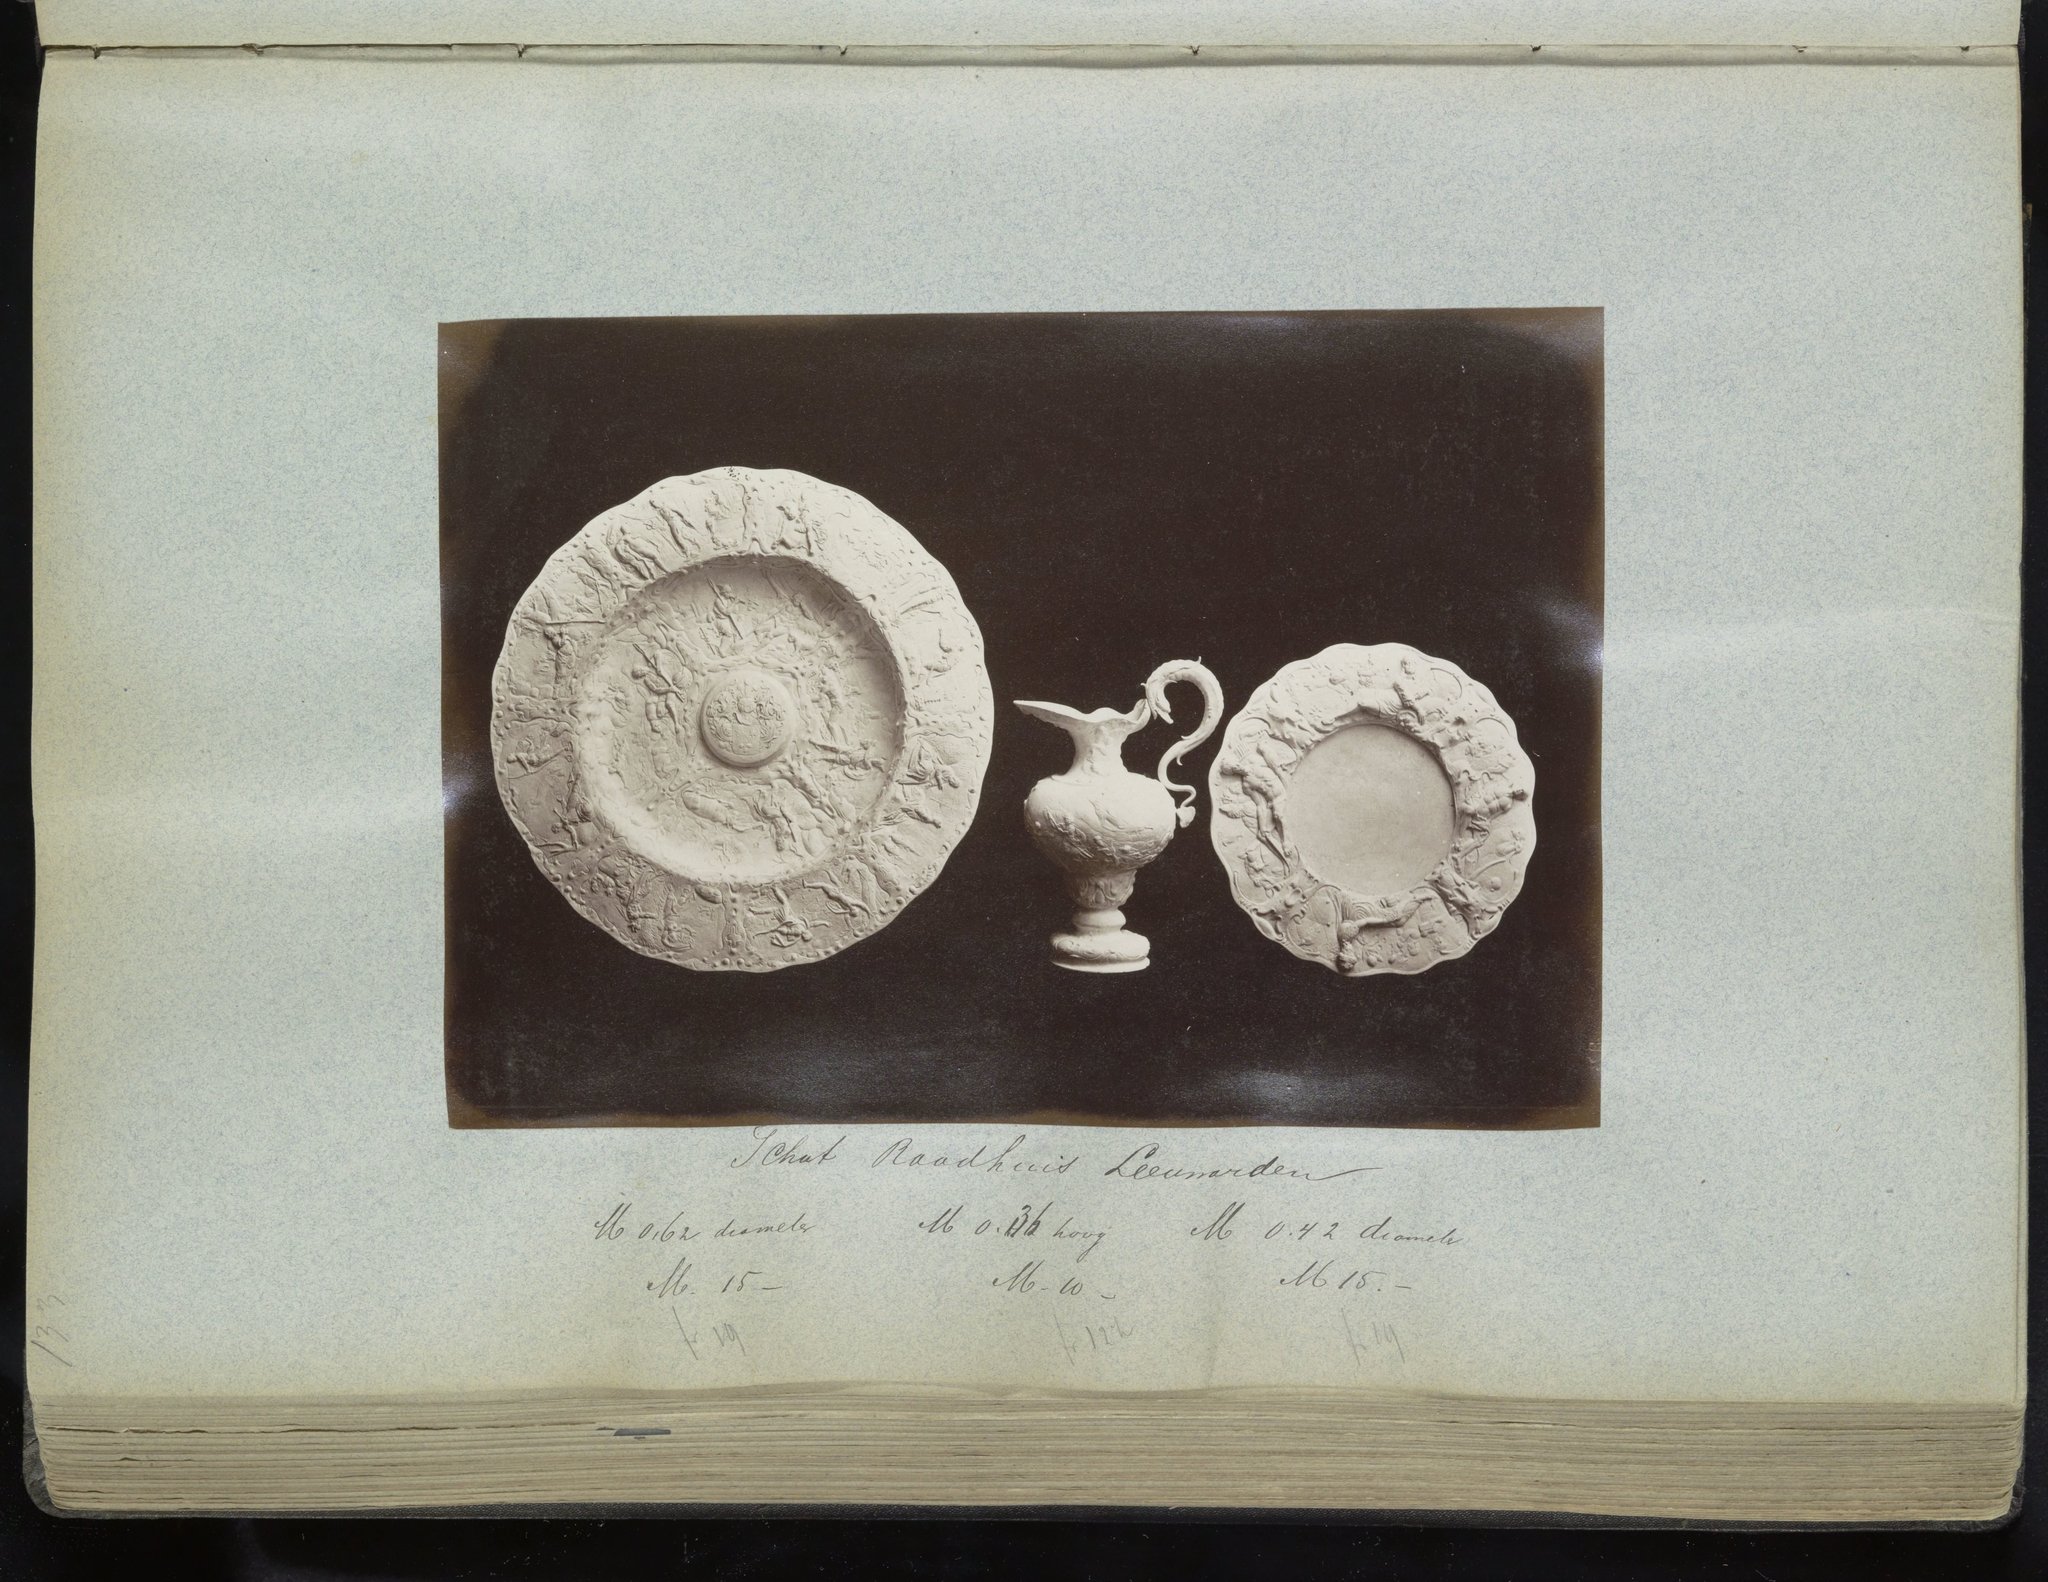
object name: album leaf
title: Drie gipsen afgietsels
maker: Anonymous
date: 1875-1900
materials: paper, photographic support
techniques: albumen print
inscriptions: annotation, annotation